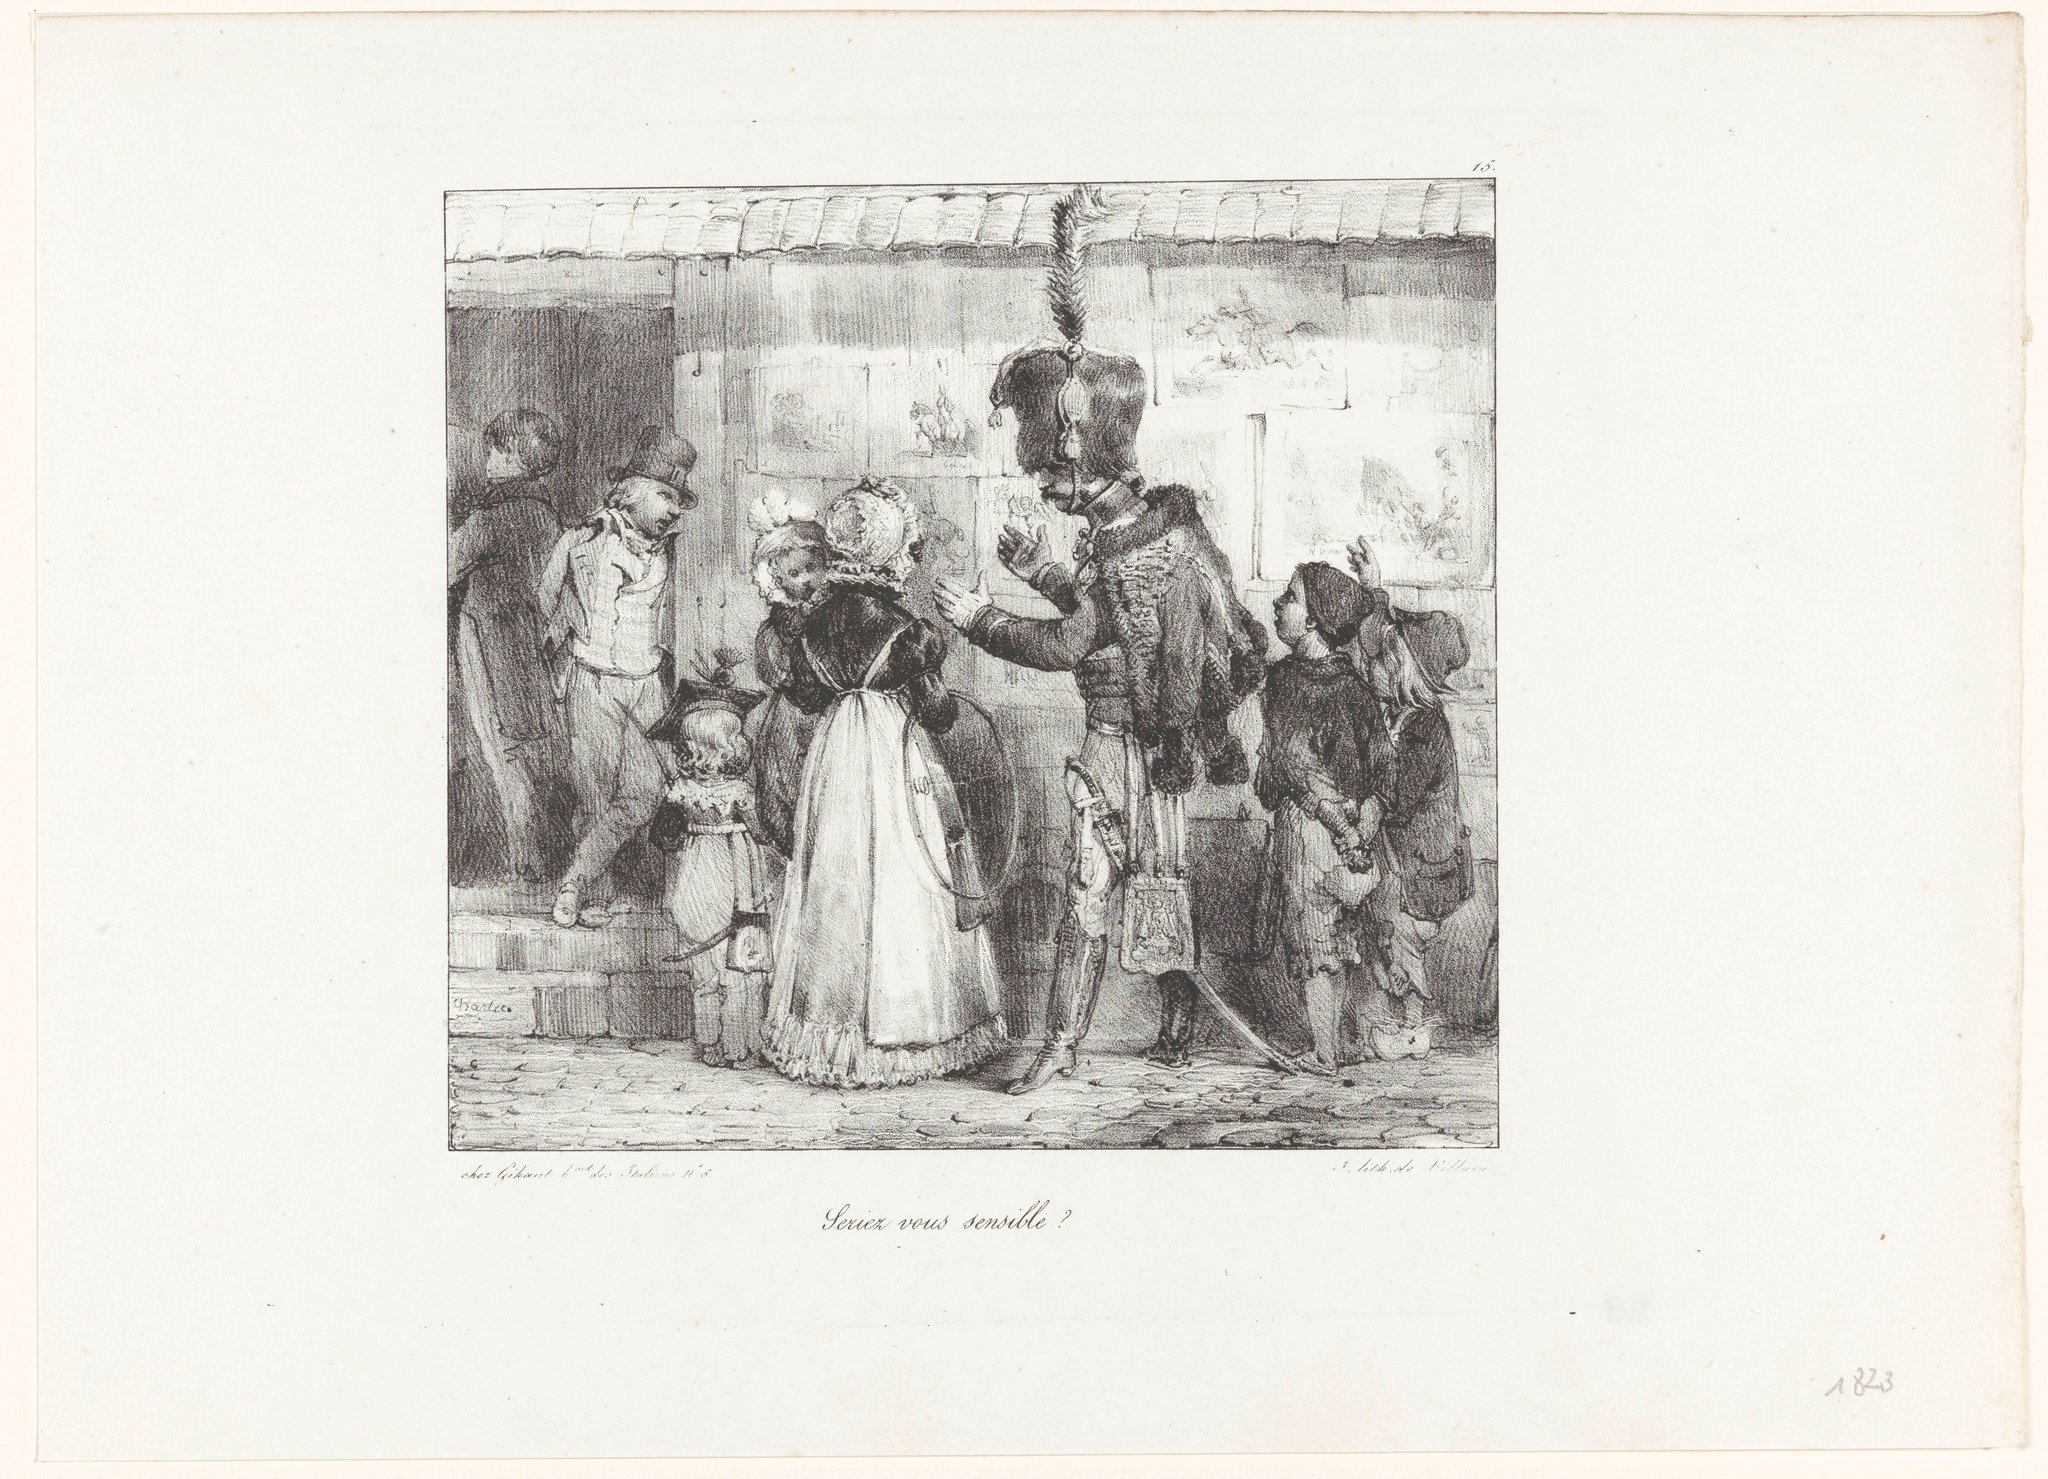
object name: print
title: Soldaat voor een prentenkraam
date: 1823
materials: paper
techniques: lithograph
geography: paris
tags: private soldier, wandering or travelling merchant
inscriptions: collector's mark: Lugt 4779, collector's mark: Lugt 4780, collector's mark: Lugt 2228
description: Een soldaat, mogelijk een chasseur, in gesprek met een vrouw voor een prentenkraam. Om hen heen kinderen. In de deuropening staat een man, mogelijk de prenthandelaar.